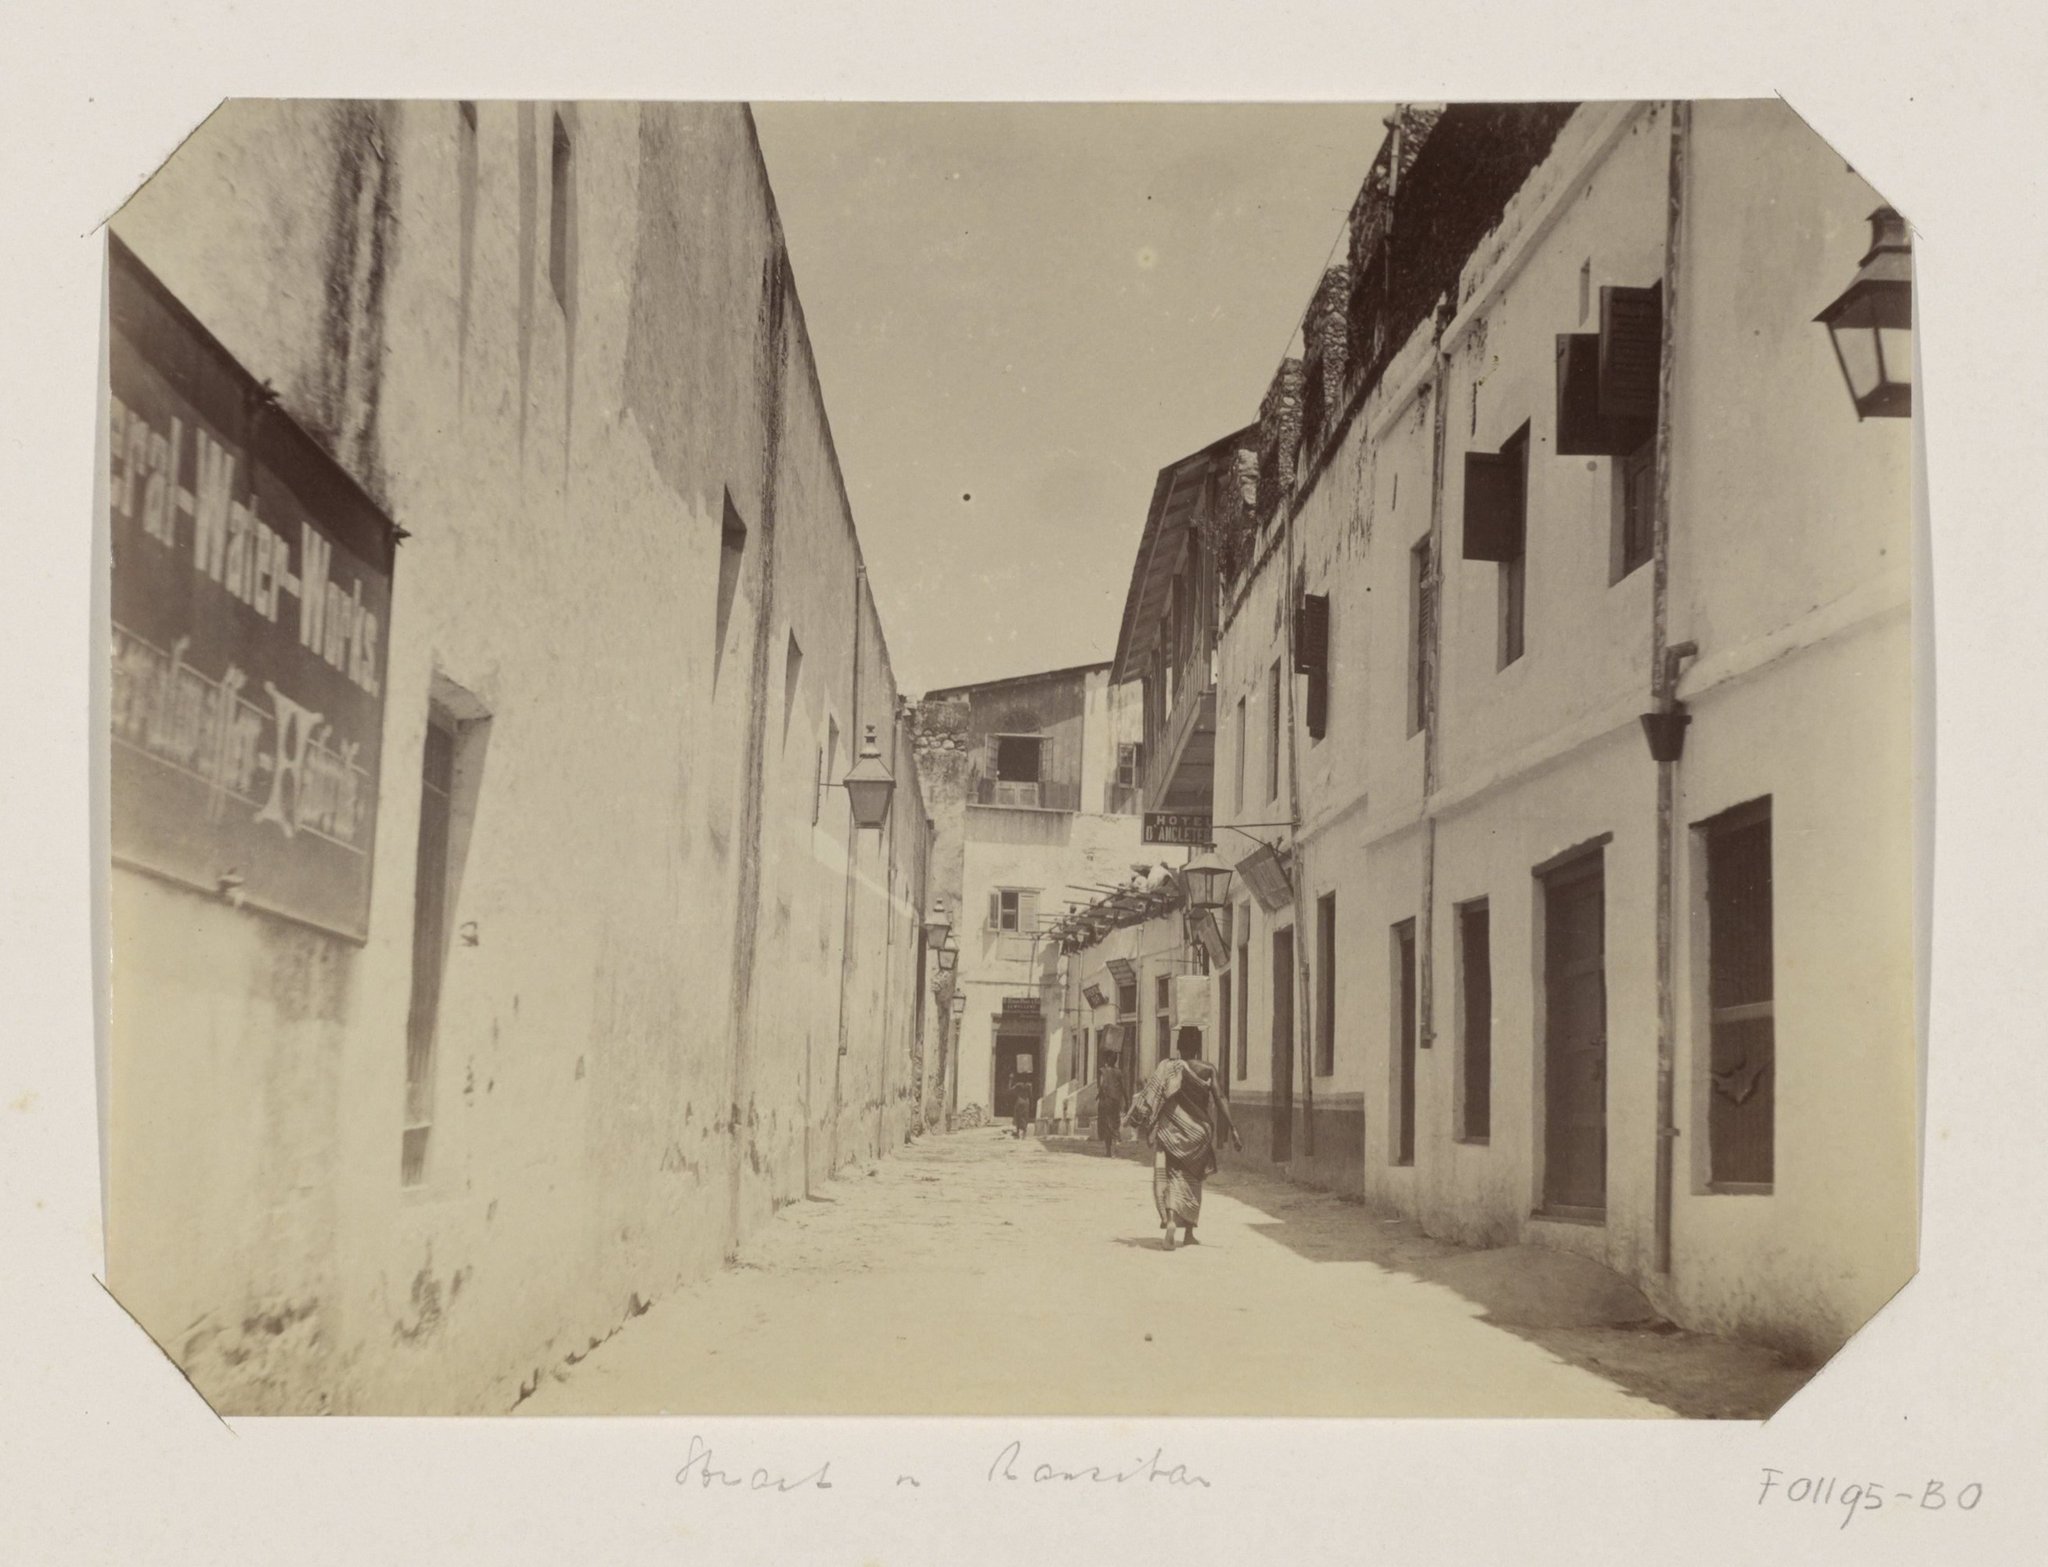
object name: photograph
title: Voorbijgangers in een straat te Zanzibar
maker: Anonymous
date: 1880-1920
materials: cardboard, paper, photographic support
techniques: albumen print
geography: zanzibar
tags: street (+ city(-scape) with figures, staffage)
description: Onderdeel van Fotoalbum van een reis door de Verenigde Staten, Honolulu, Nederlands-Indië, Aden, Zanzibar en Zuidelijk Afrika.